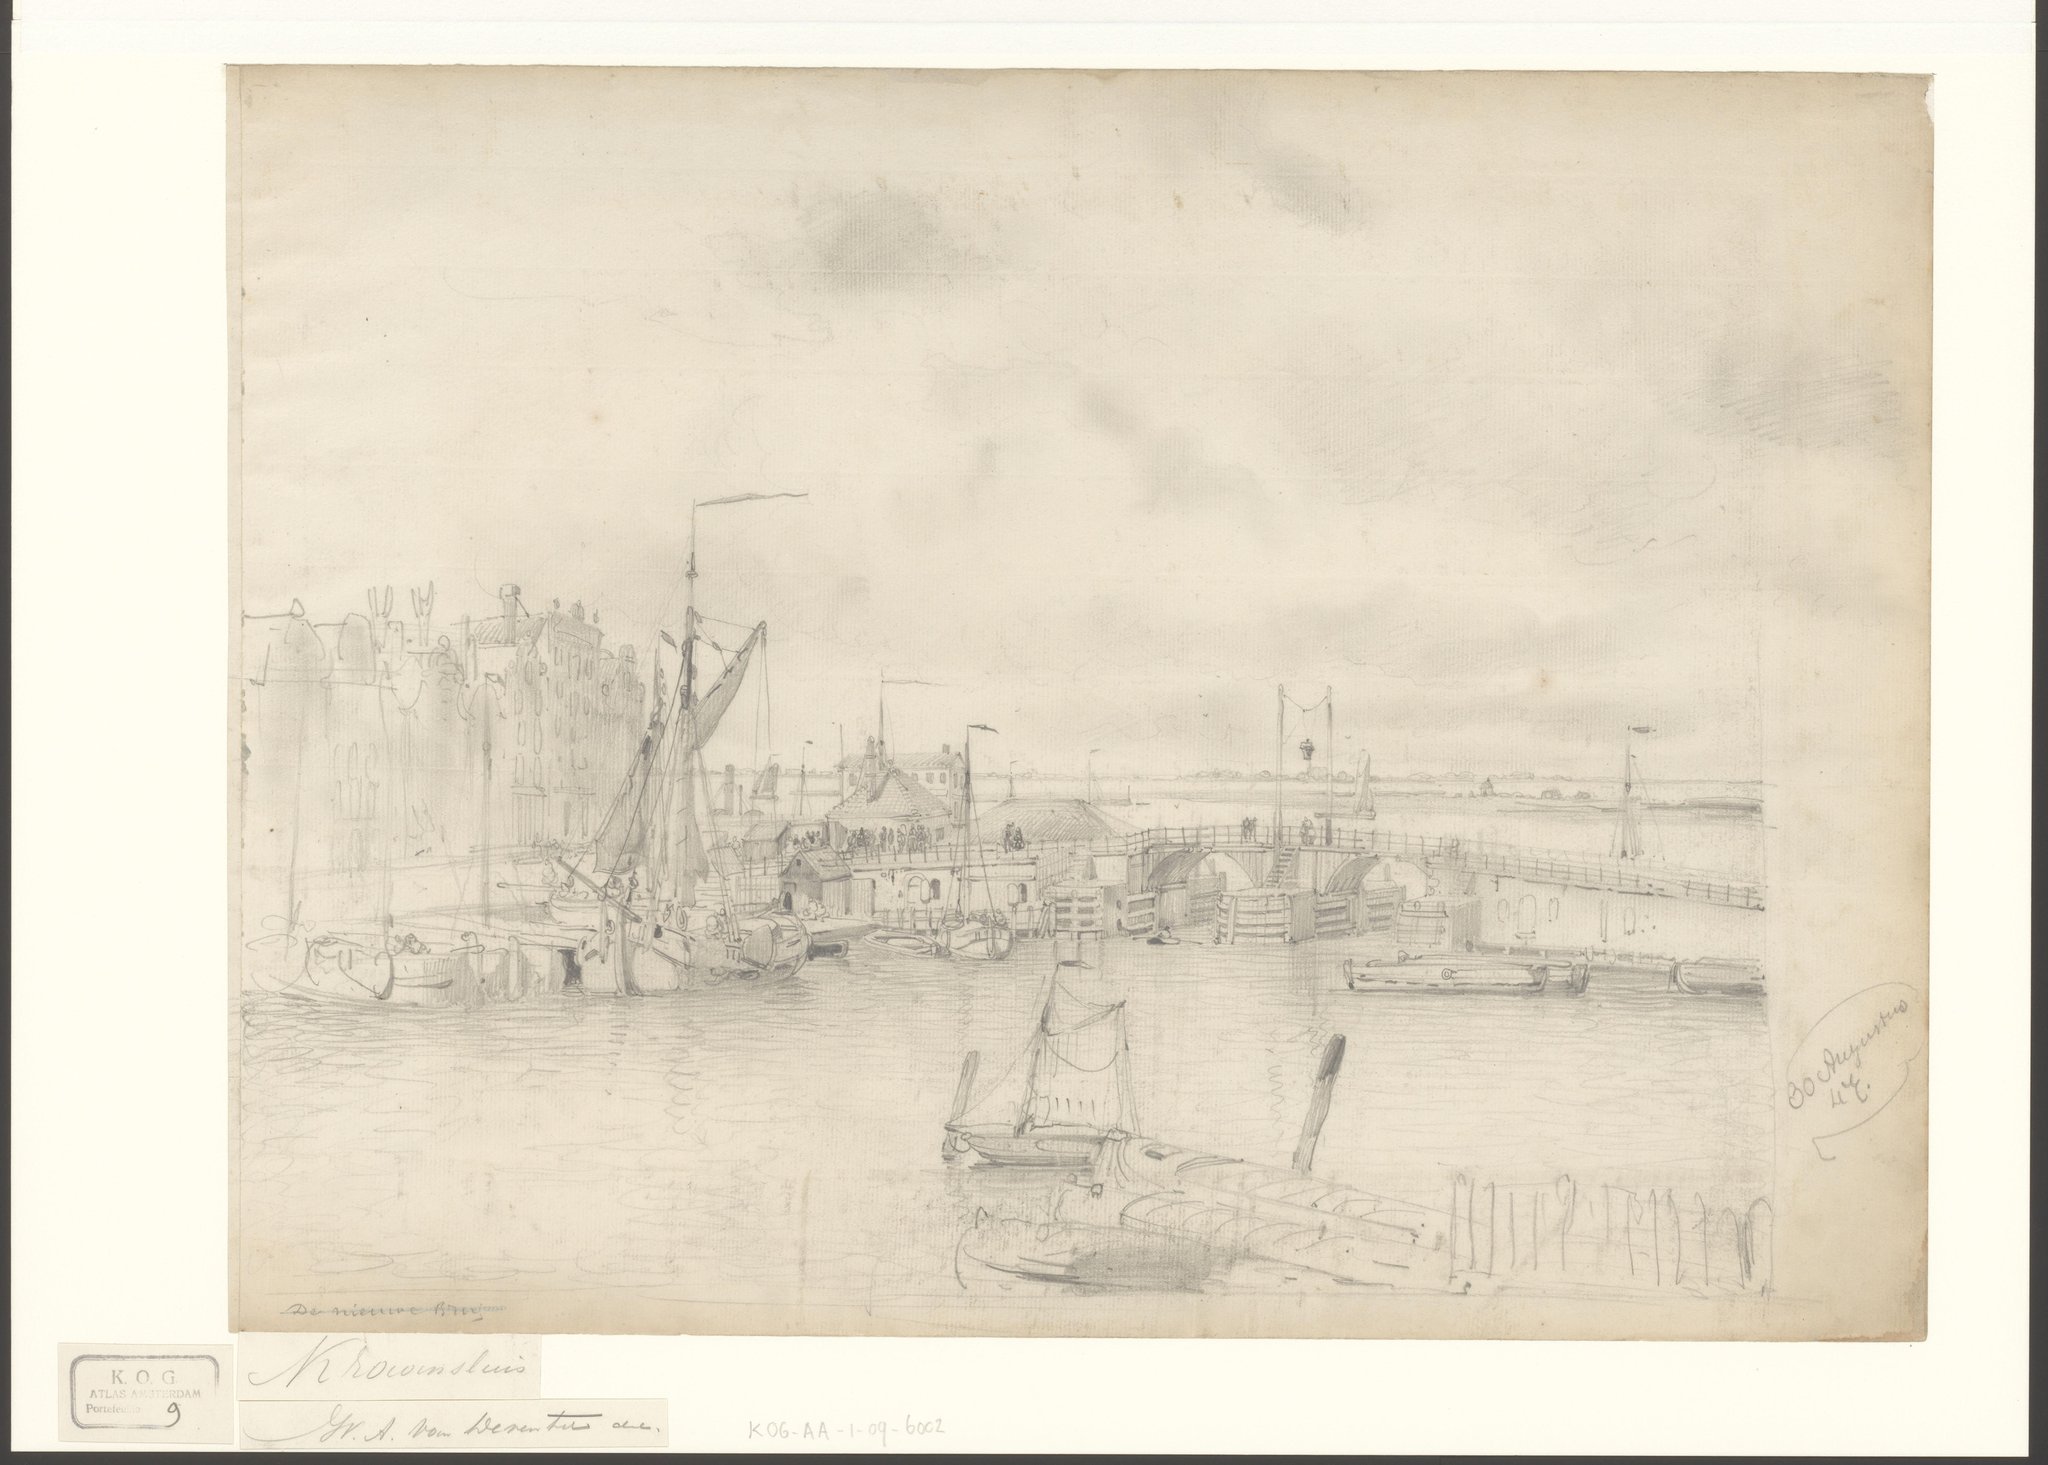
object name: drawing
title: Gezicht op de Kraansluis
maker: willem anthonie van deventer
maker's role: draughtsman, painter, print maker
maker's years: 1824-1893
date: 1847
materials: paper, pencil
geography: amsterdam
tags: sluice, weir, sailing-ship, sailing-boat, city-view in general; 'veduta', canal, bridge in city across river, canal, etc.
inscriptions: inscription: ‘De nieuwe Brug / 30 Augustus / 47.’, inscription: ‘Port. 9’, collector's mark: ‘9’ Lugt 1641b, inscription: ‘Kraansluis / W. A. van Deventer del.’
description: Onderwerpsrubriek binnen de Atlas Amsterdam: Haarlemmerplein, Halvemaansteeg, Handboogstraat, Handelskade, Haringpakkerij, Hartenstraat, Hasseltsteeg (Dirk van), Heerengracht.